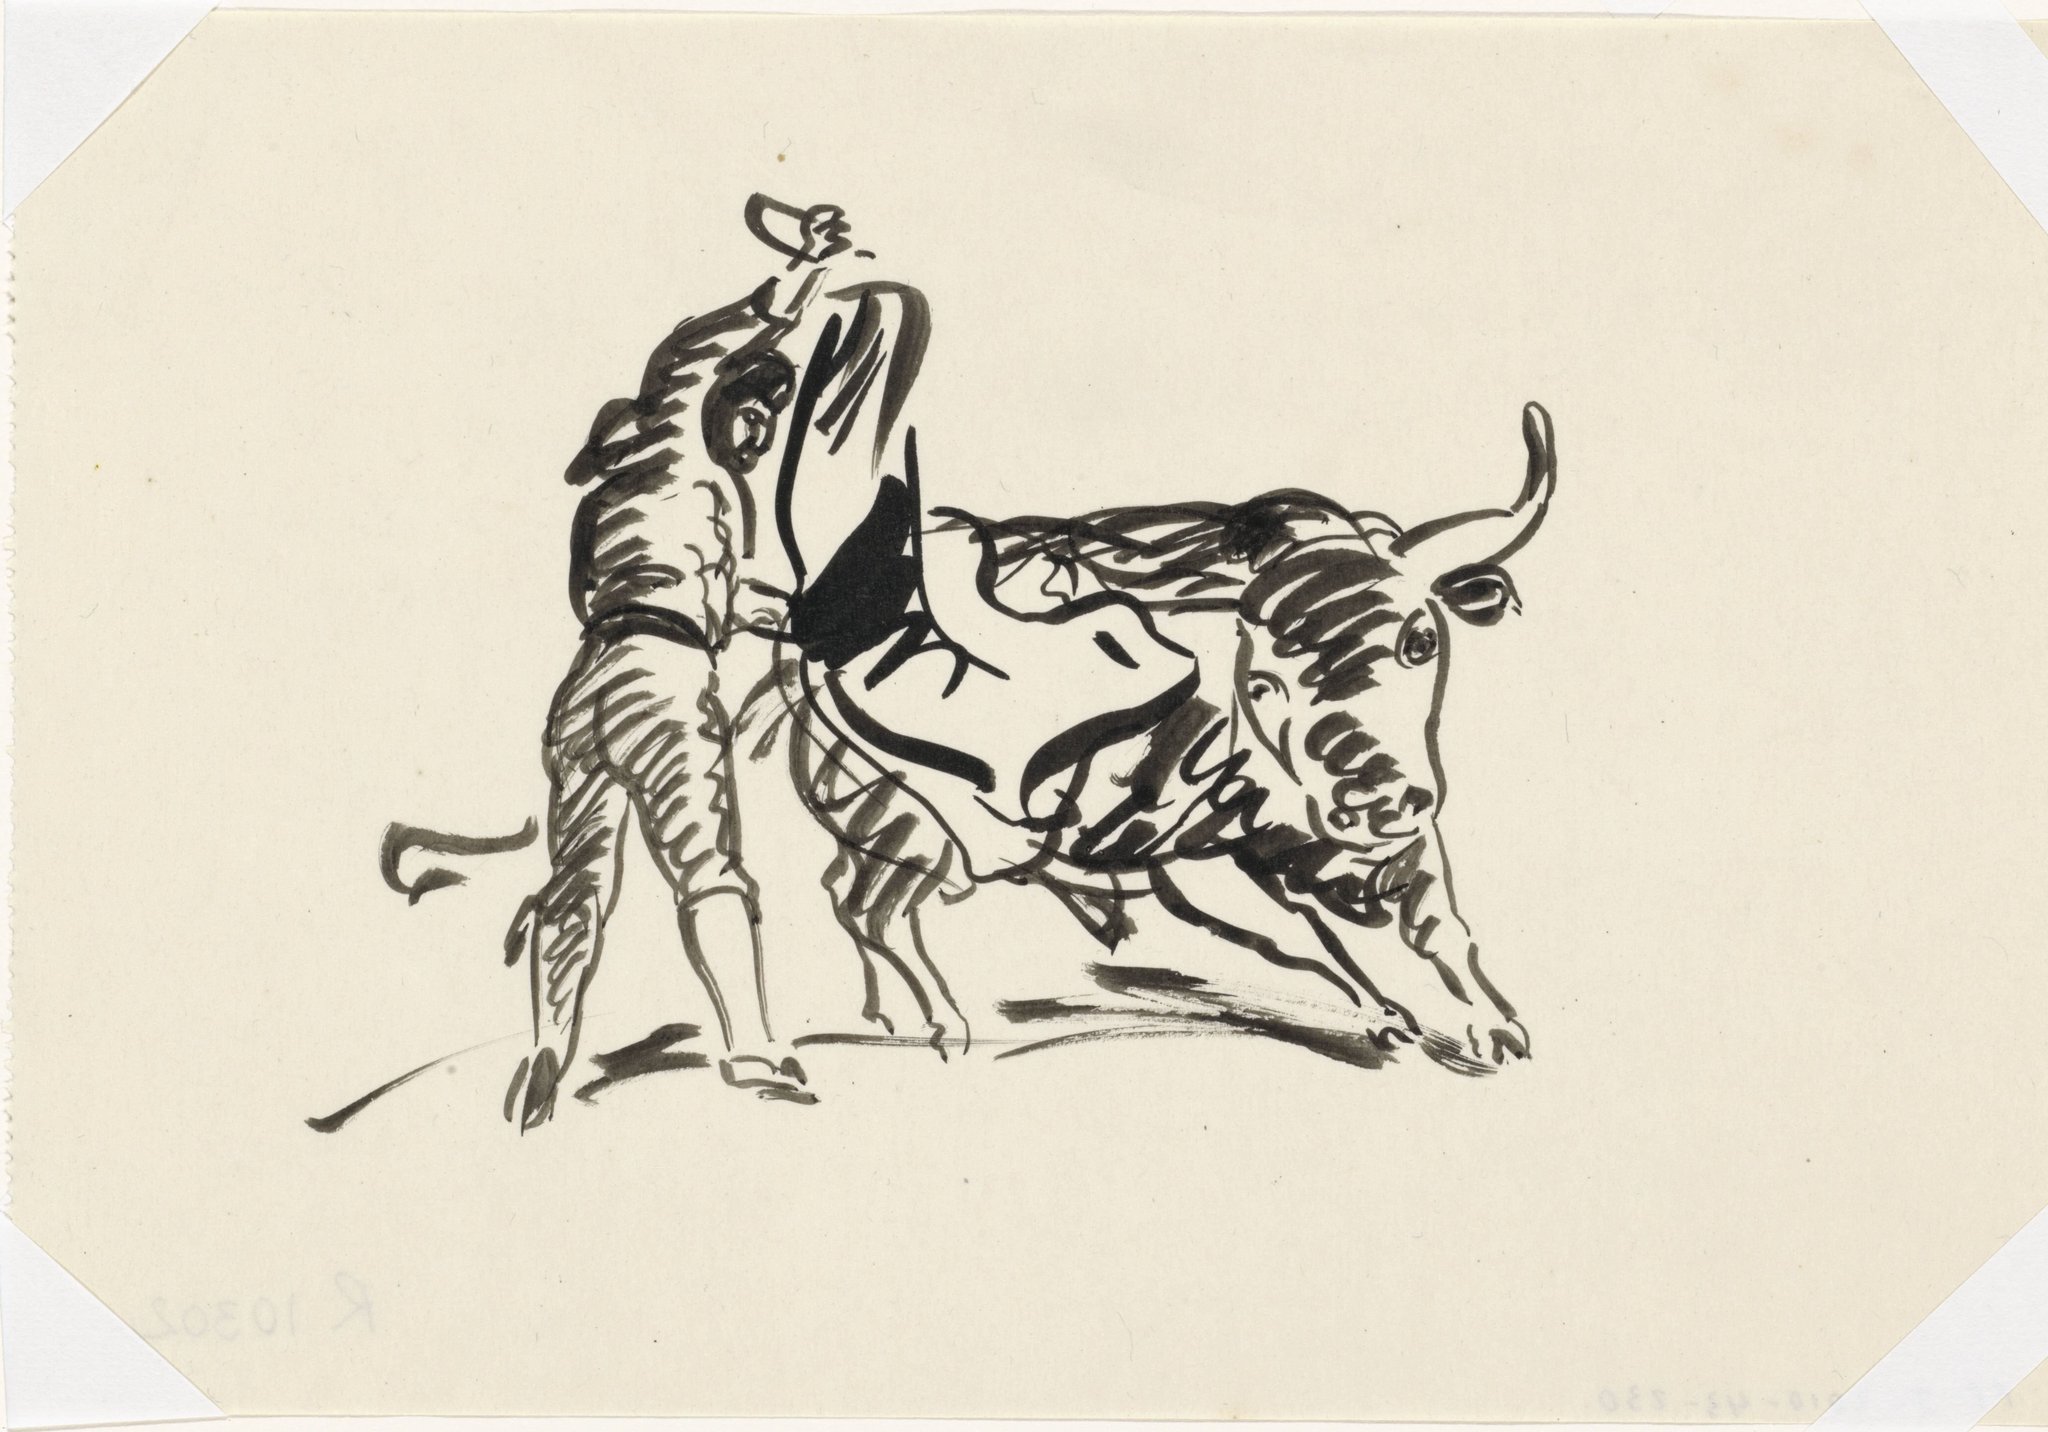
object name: drawing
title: Zonder titel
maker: leo gestel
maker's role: draughtsman, print maker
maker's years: 1881-1941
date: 1935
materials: ink, paper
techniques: brush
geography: spain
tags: bullfight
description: Stierenvechter met opgeheven muleta (rode lap), waar ondervandaan rechts van hem een stier frontaal te voorschijn komt.